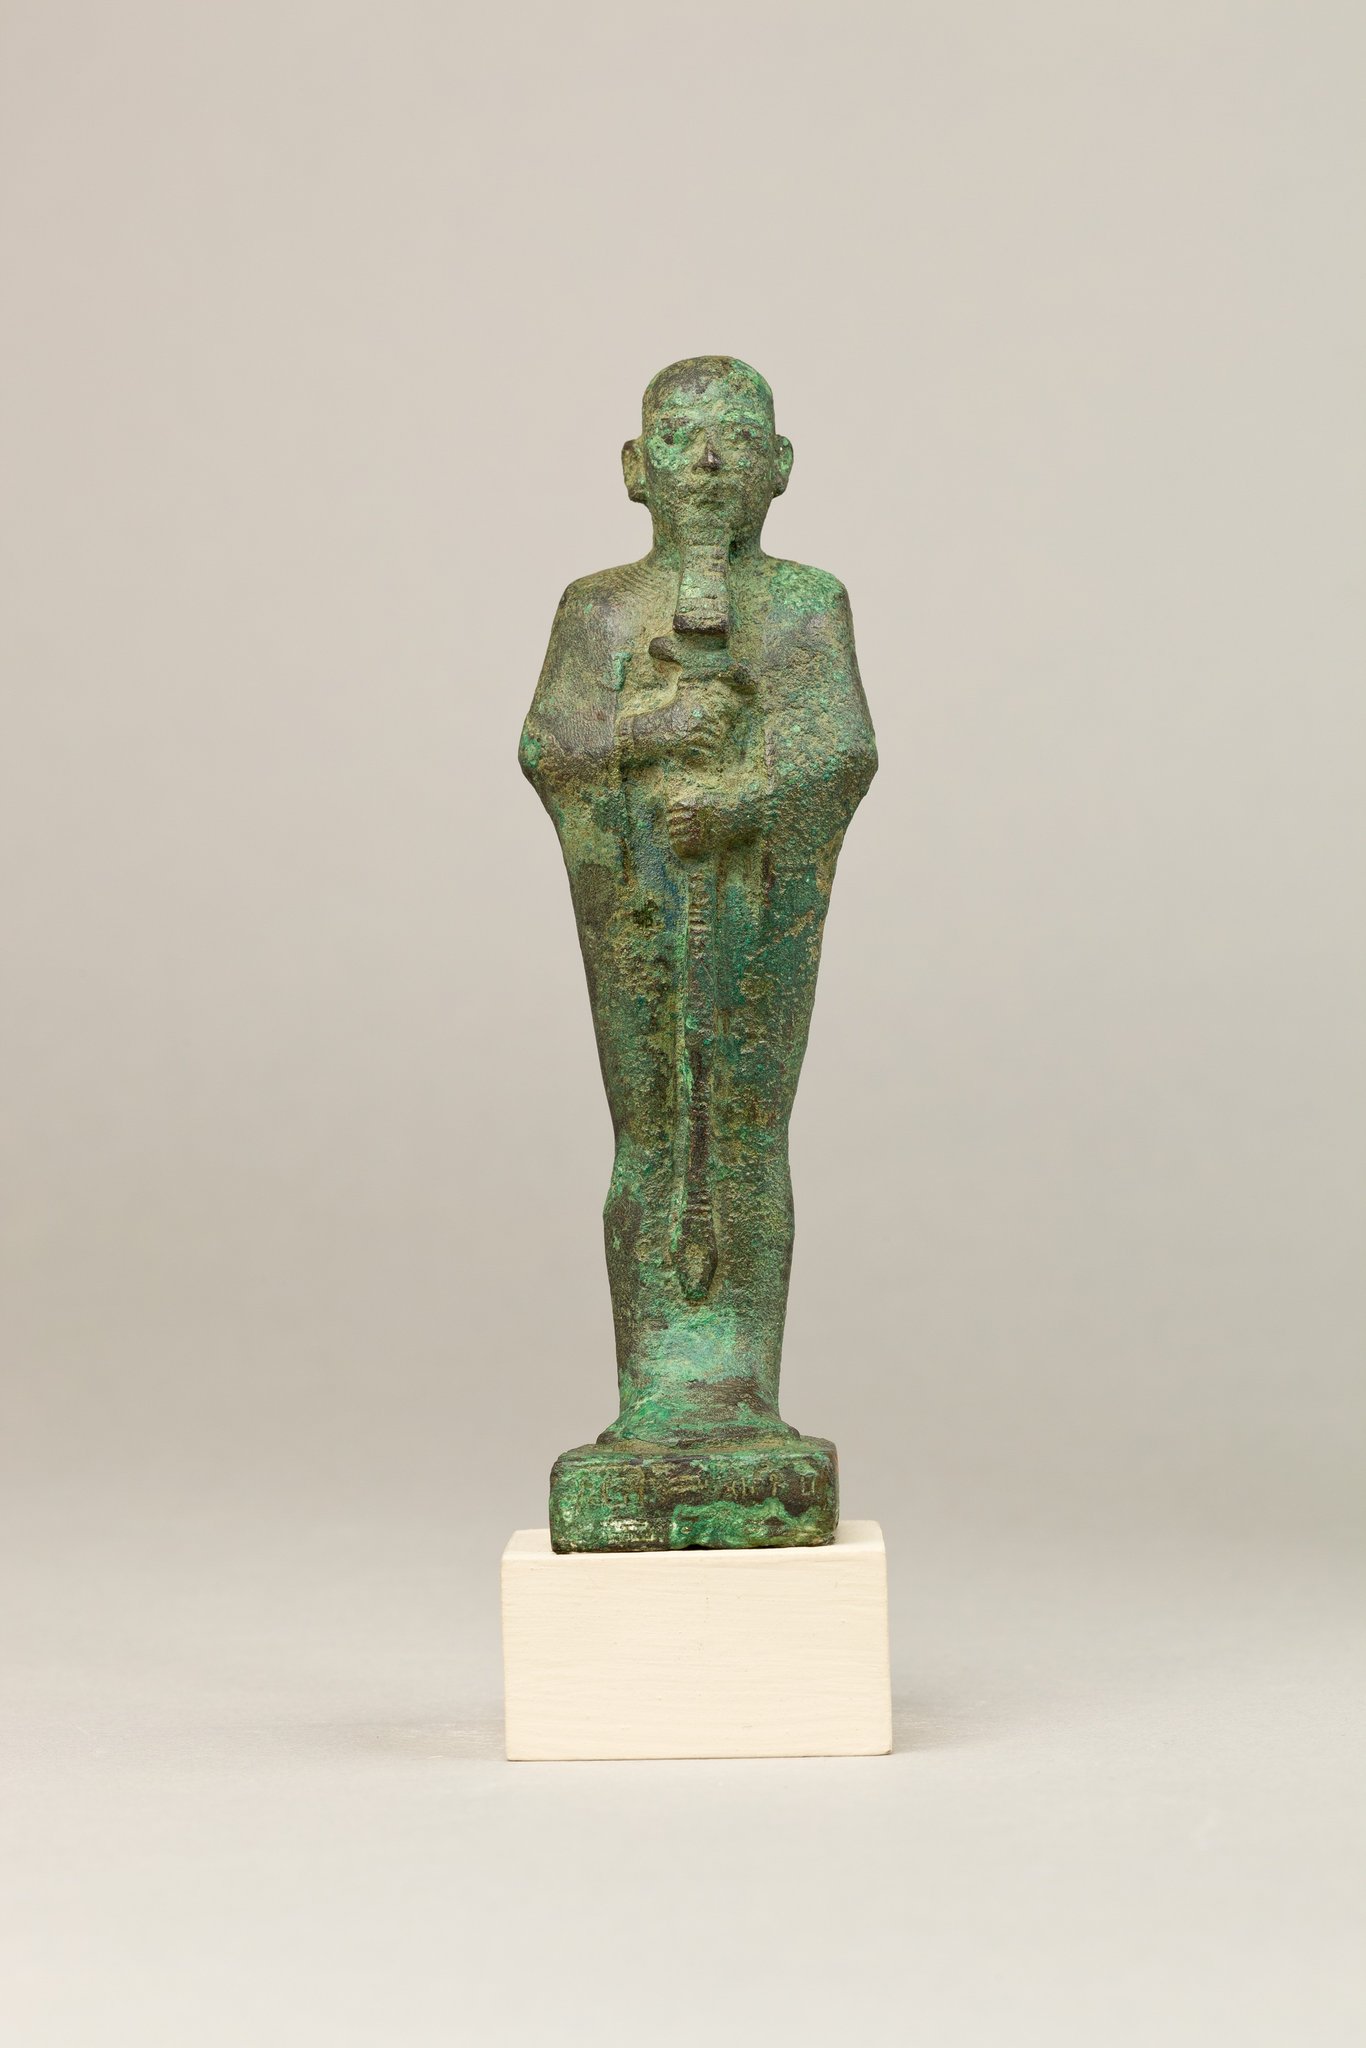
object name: statuette, ptah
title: Ptah, inscription obliterated except for the god's name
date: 664-630 BCE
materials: metal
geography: egypt